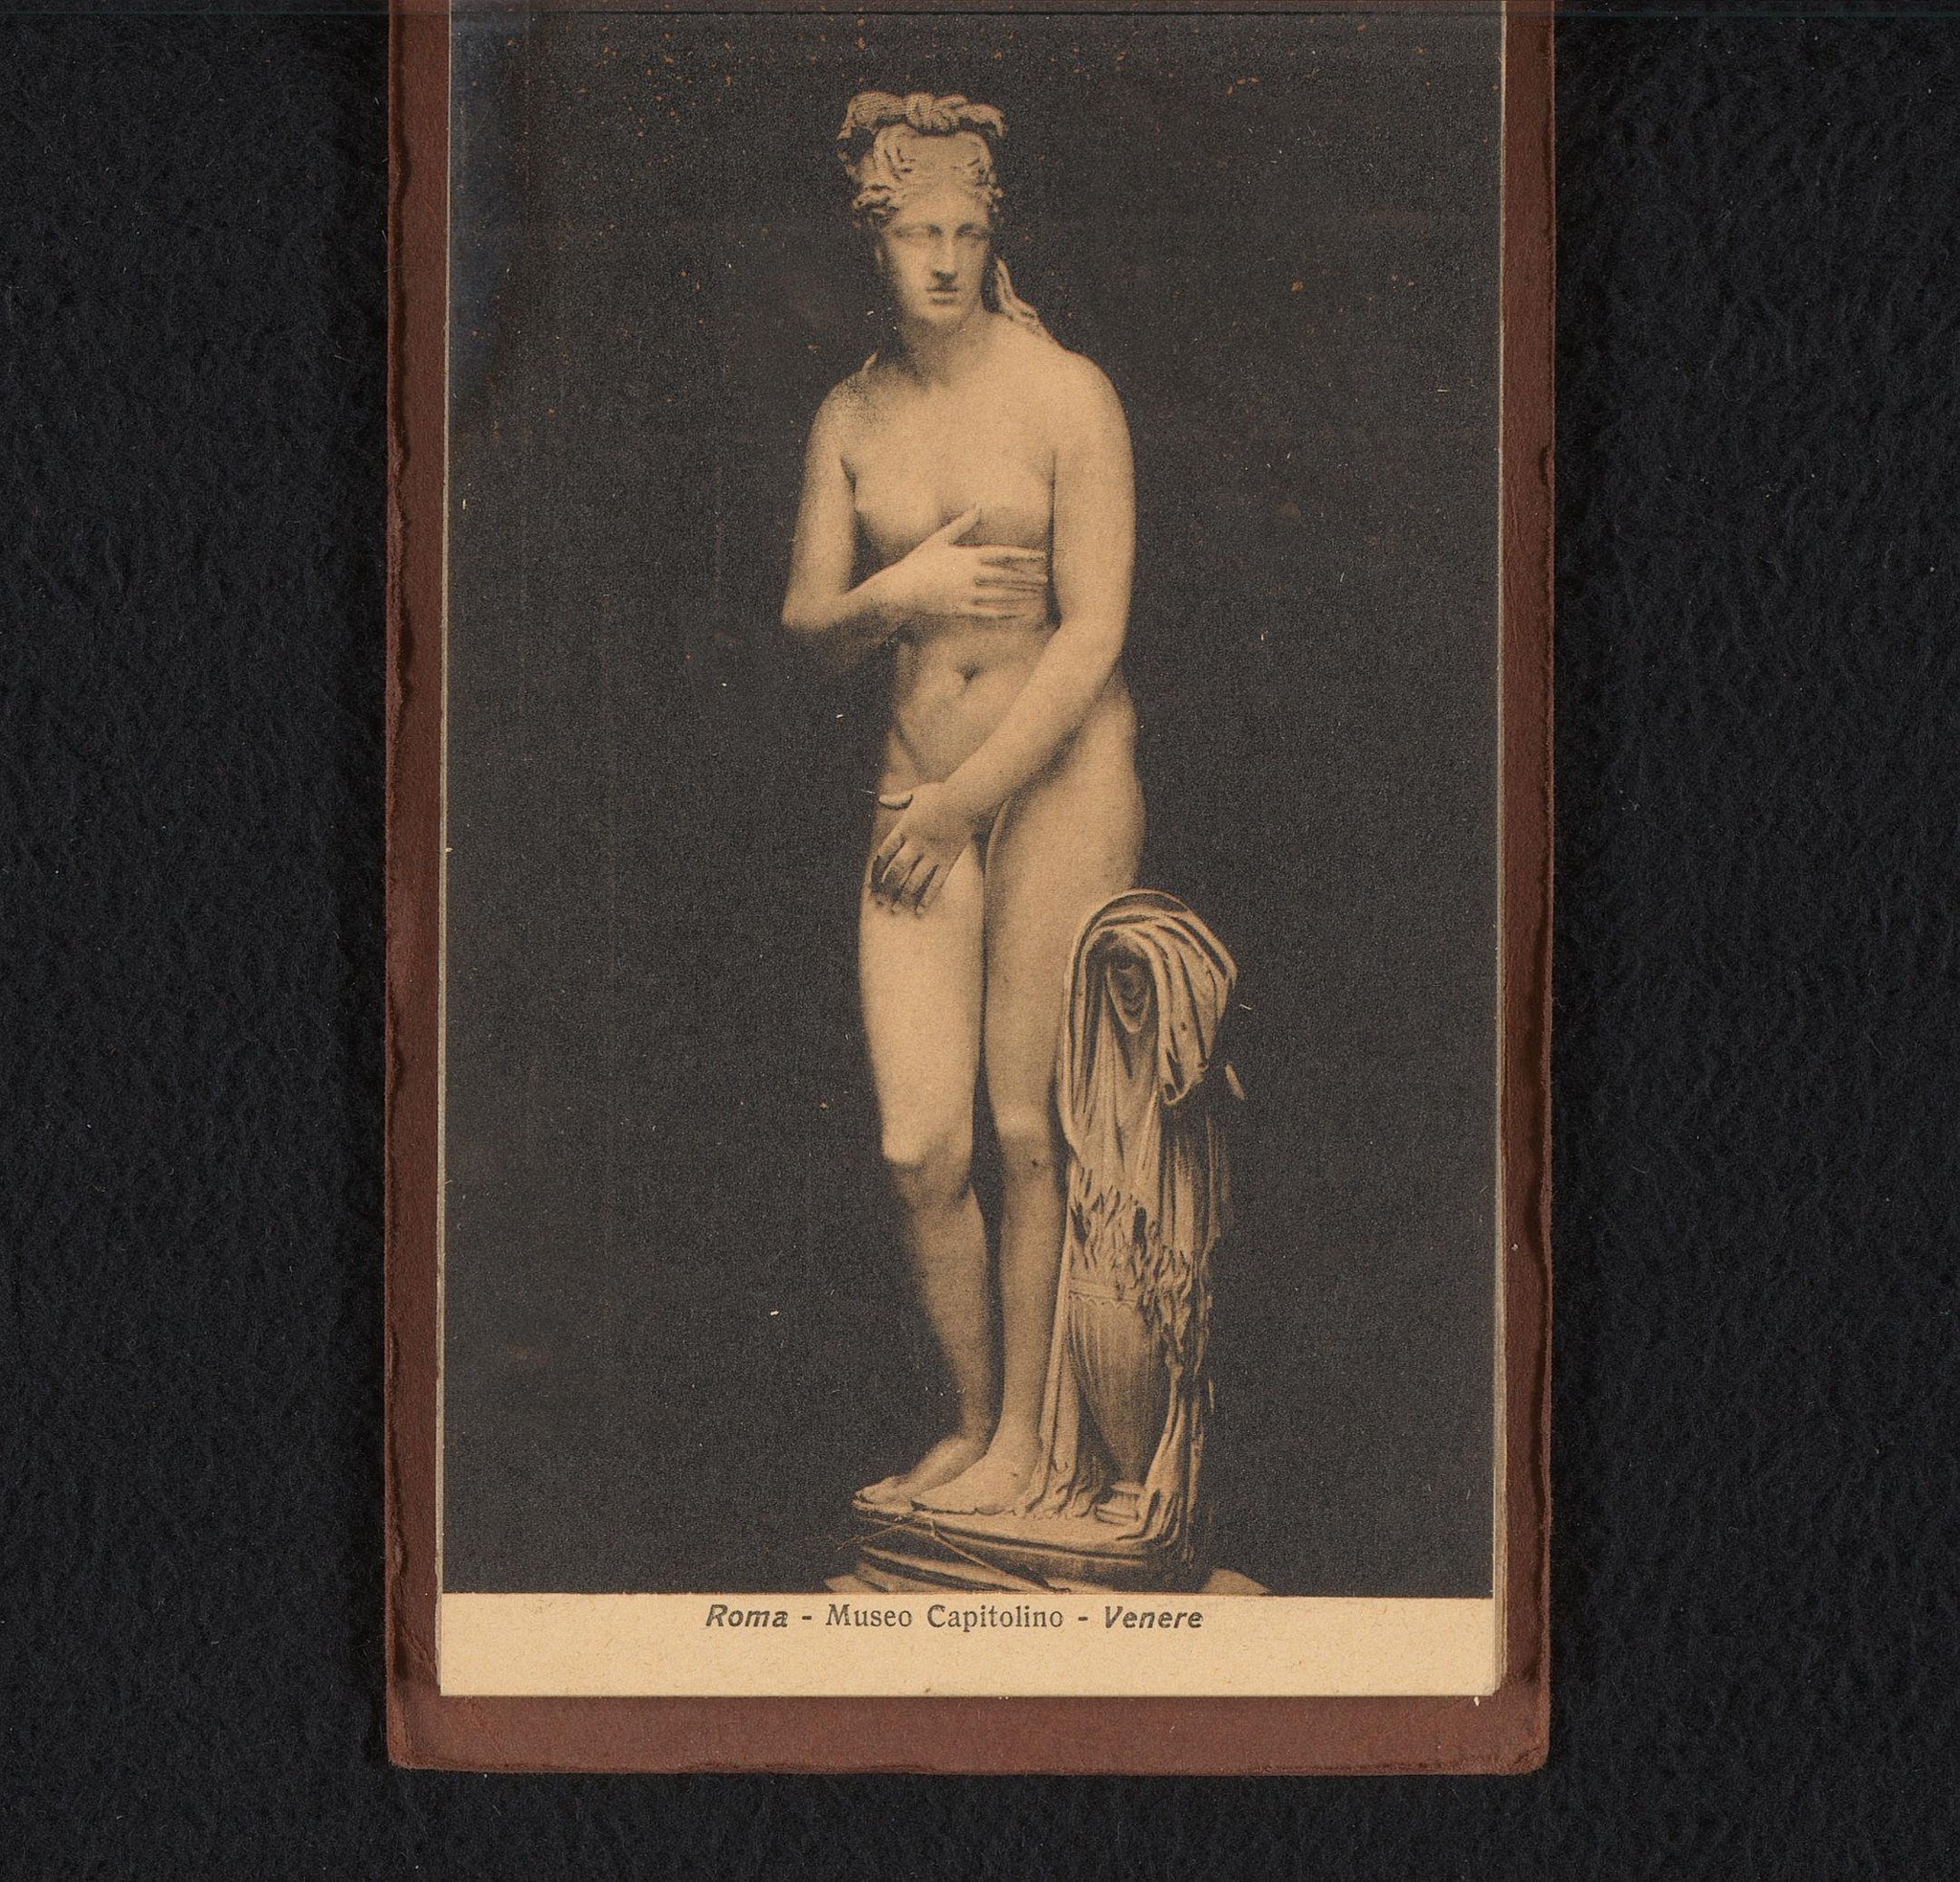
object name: photomechanical print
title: Roma - Museo Capitolino - Venere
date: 1905-1930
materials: cardboard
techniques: photograph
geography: rome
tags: statues, paintings, etc. ~ objects of worship in roman religion, permanent exhibition, museum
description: Prentbriefkaart maakt deel uit van een album.